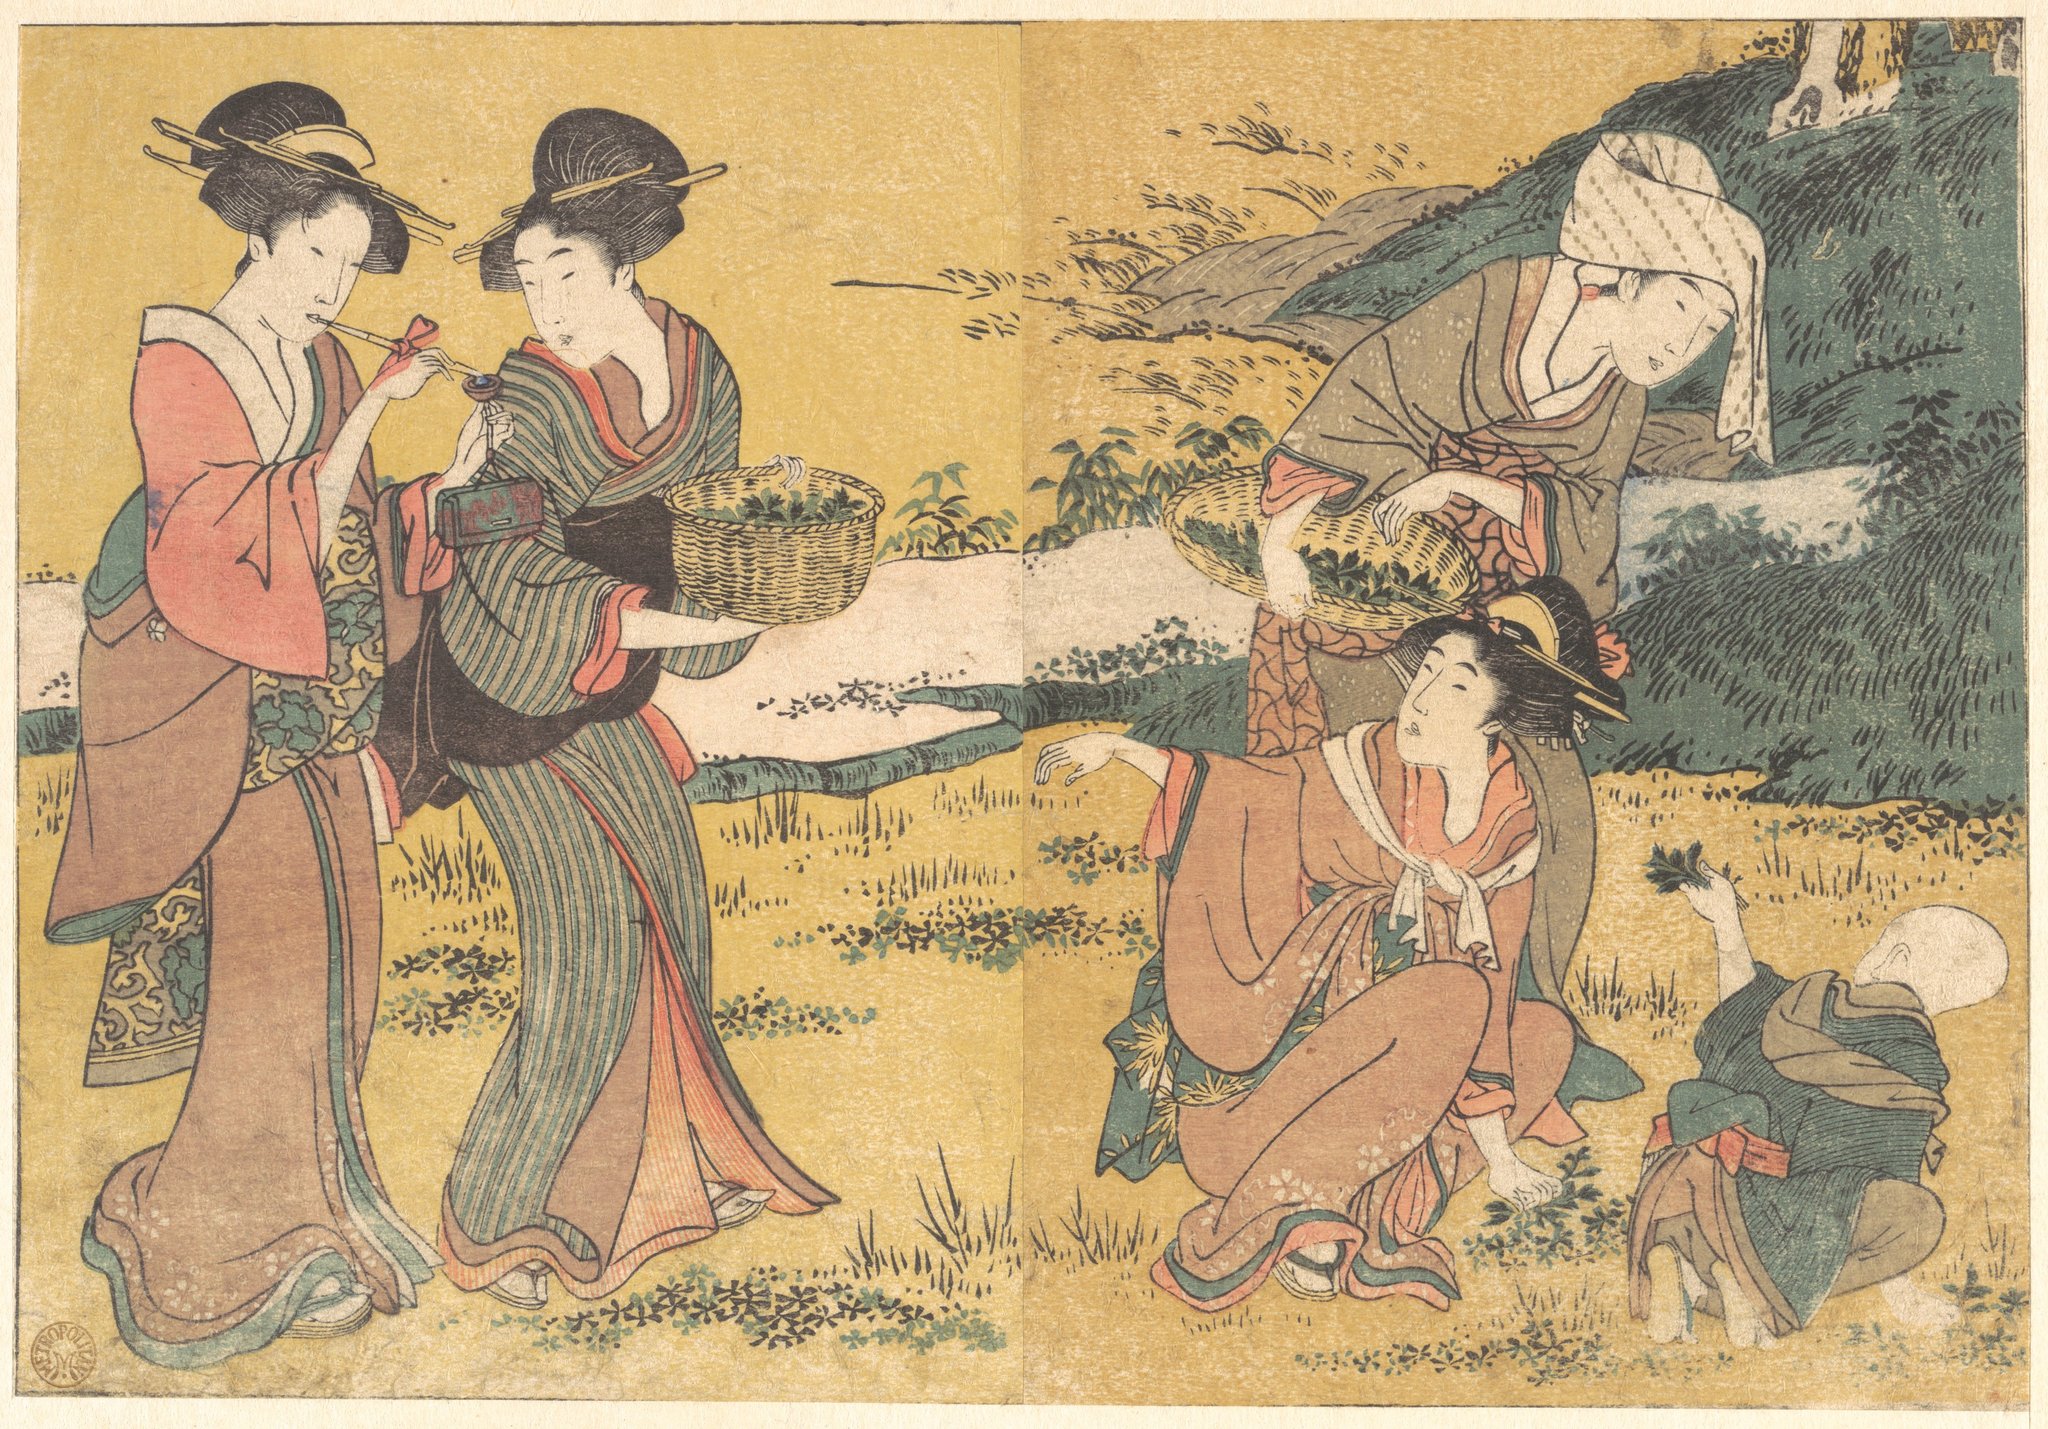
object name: woodblock print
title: Girls Picking Green Leaves, from the illustrated book Flowers of the Four Seasons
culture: japanese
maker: kitagawa utamaro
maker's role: artist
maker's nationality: japanese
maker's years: 1754-1806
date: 1801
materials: ink, paper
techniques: woodblock print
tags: women